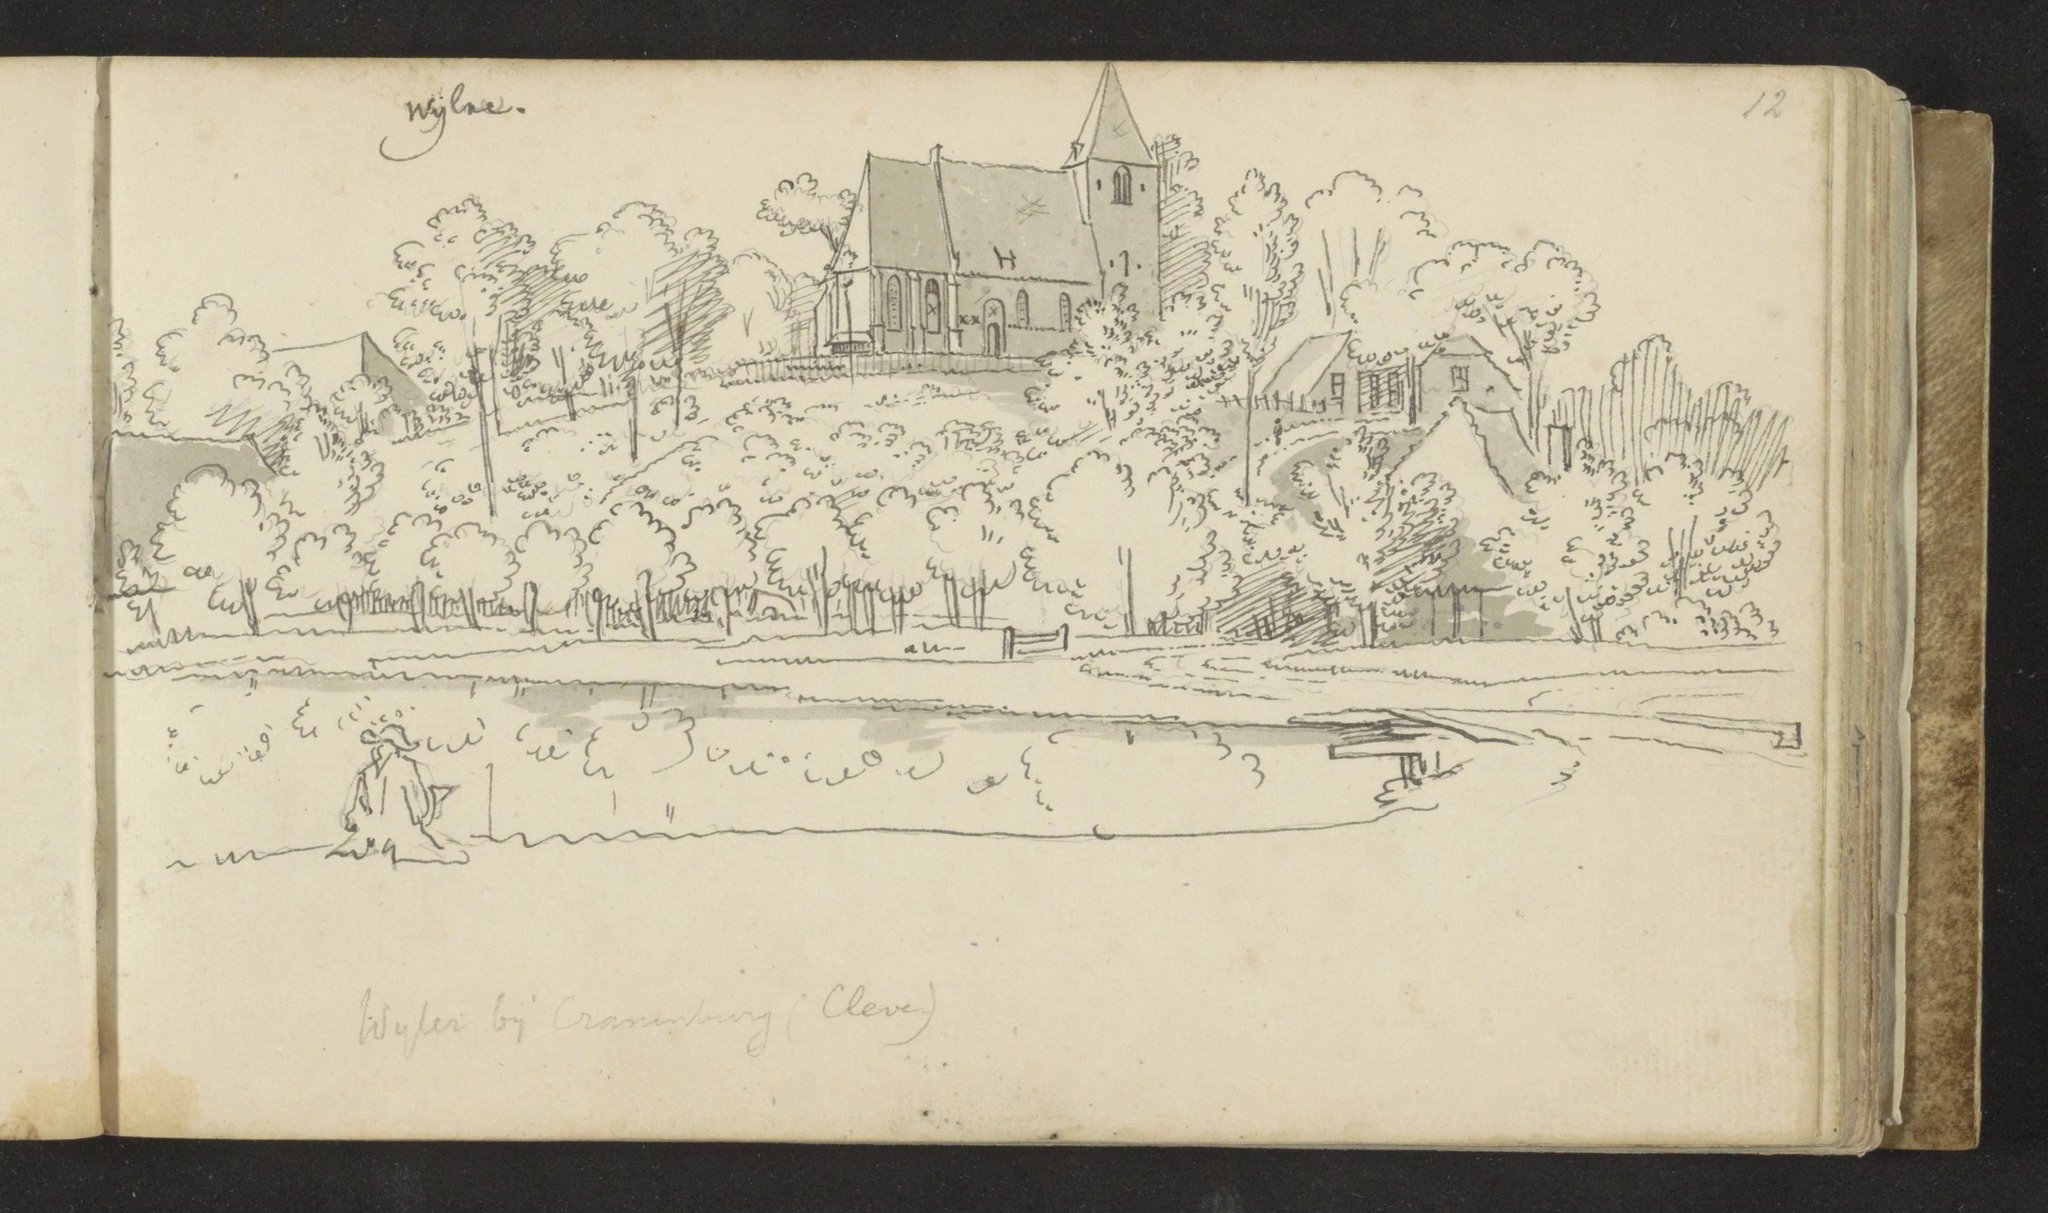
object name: sketchbook leaf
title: Gezicht op Wyler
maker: abraham de haen (ii)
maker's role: draughtsman, print maker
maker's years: 1707-1748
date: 1732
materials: ink, paper, pencil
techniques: brush, pen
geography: wyler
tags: village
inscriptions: annotation: ‘Wijlre/ Wyler bij Cranenburg (Cleve)’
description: Blad 12 recto uit een schetsboek met 51 bladen.